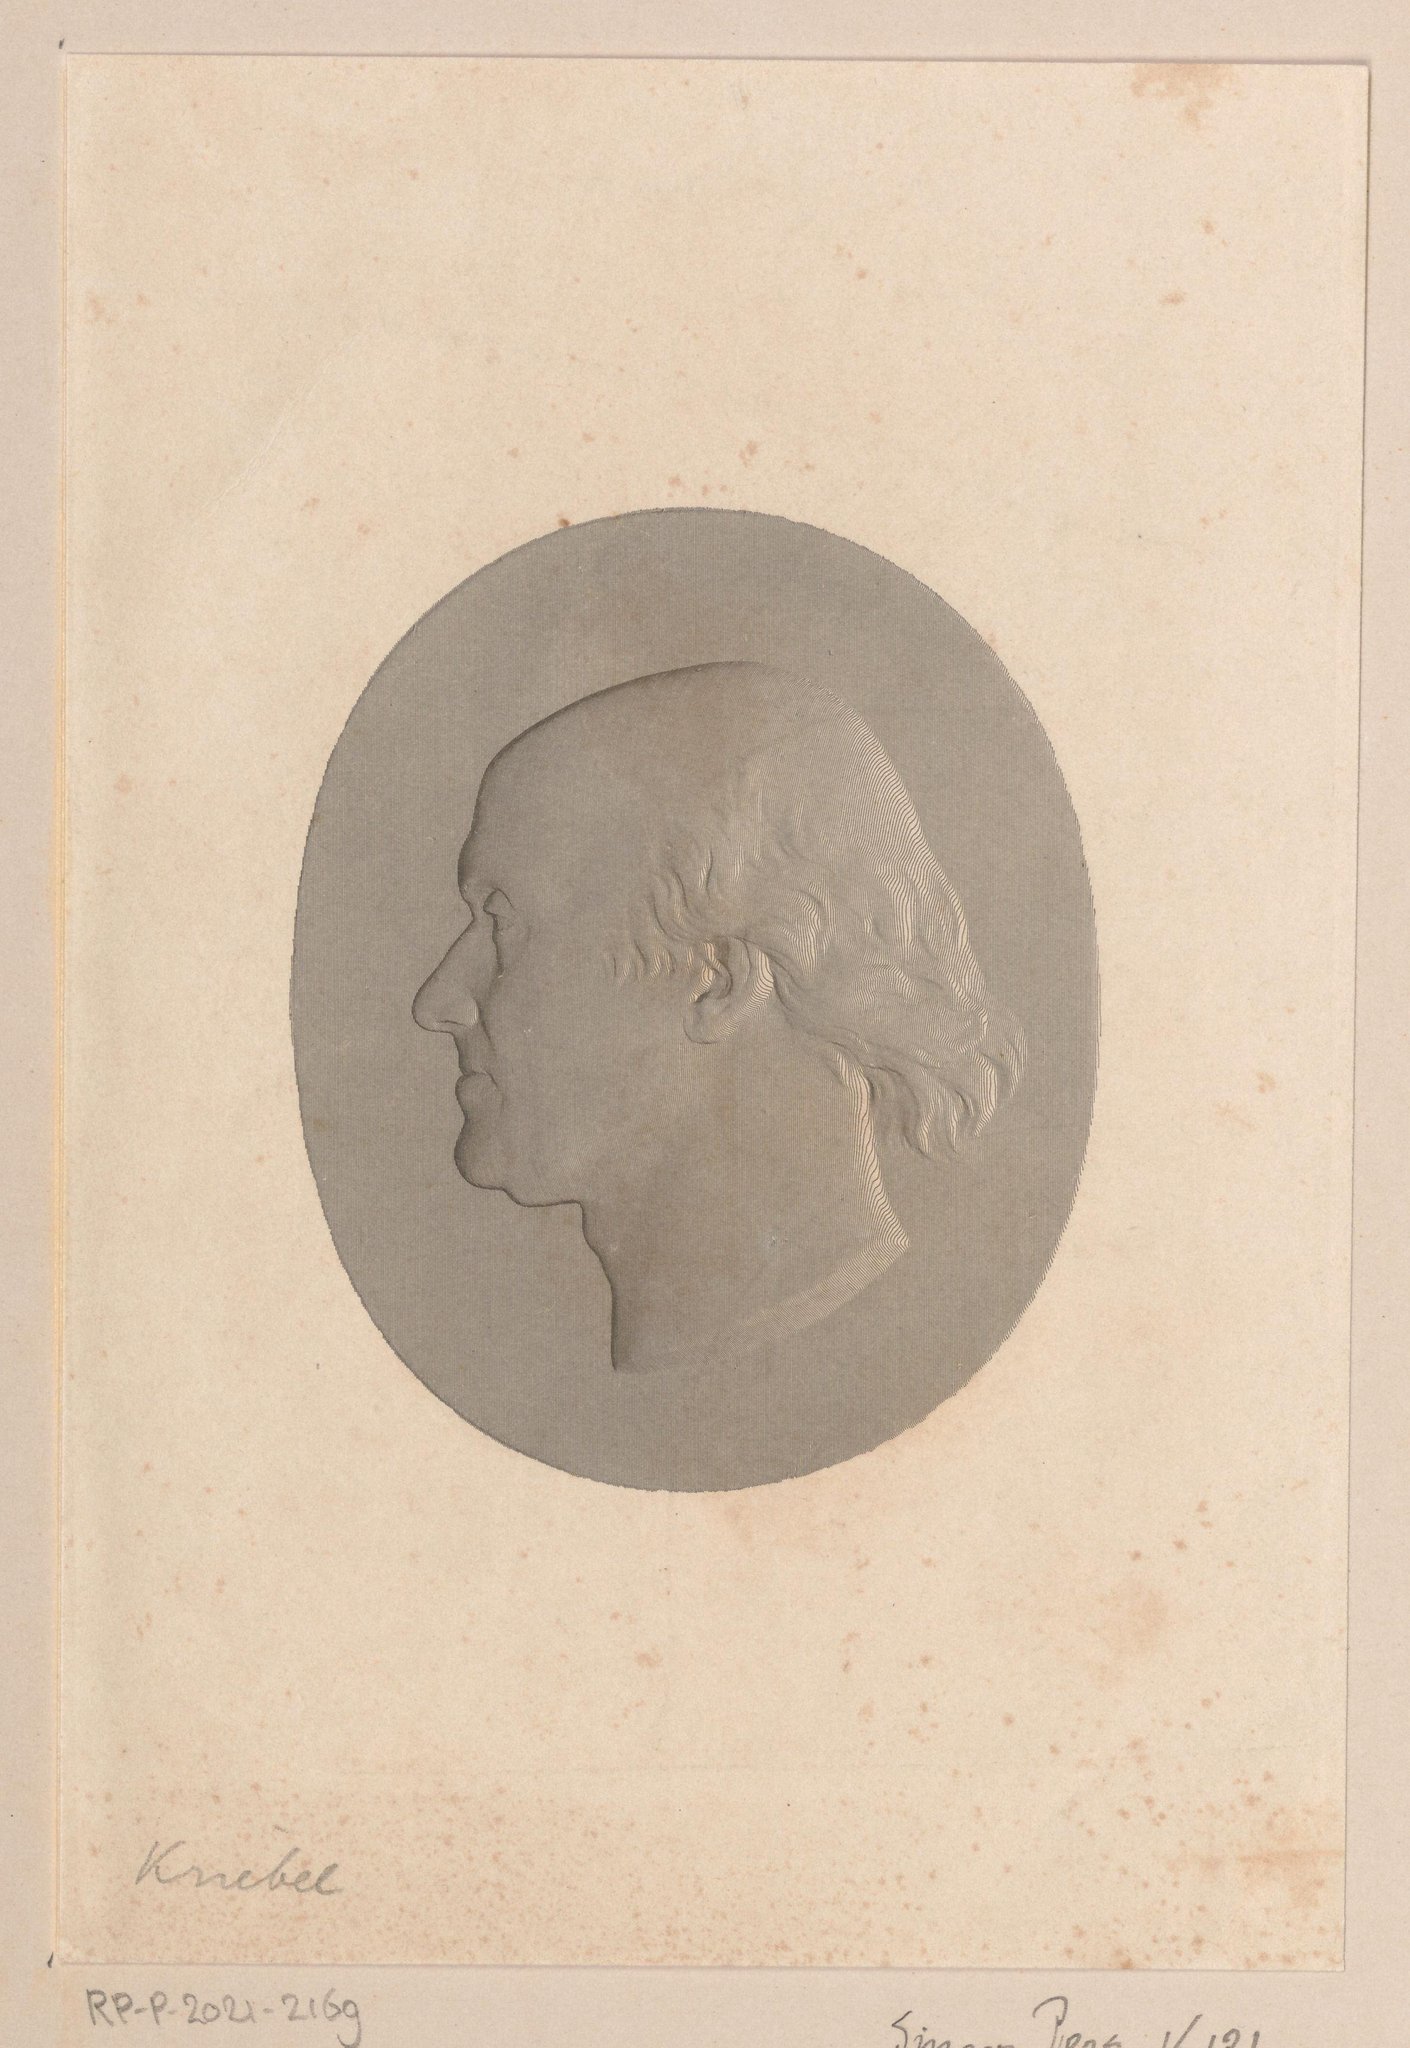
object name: print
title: Portret van Karl Ludwig von Knebel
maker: Anonymous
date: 1774-1849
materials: paper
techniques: engraving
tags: historical persons